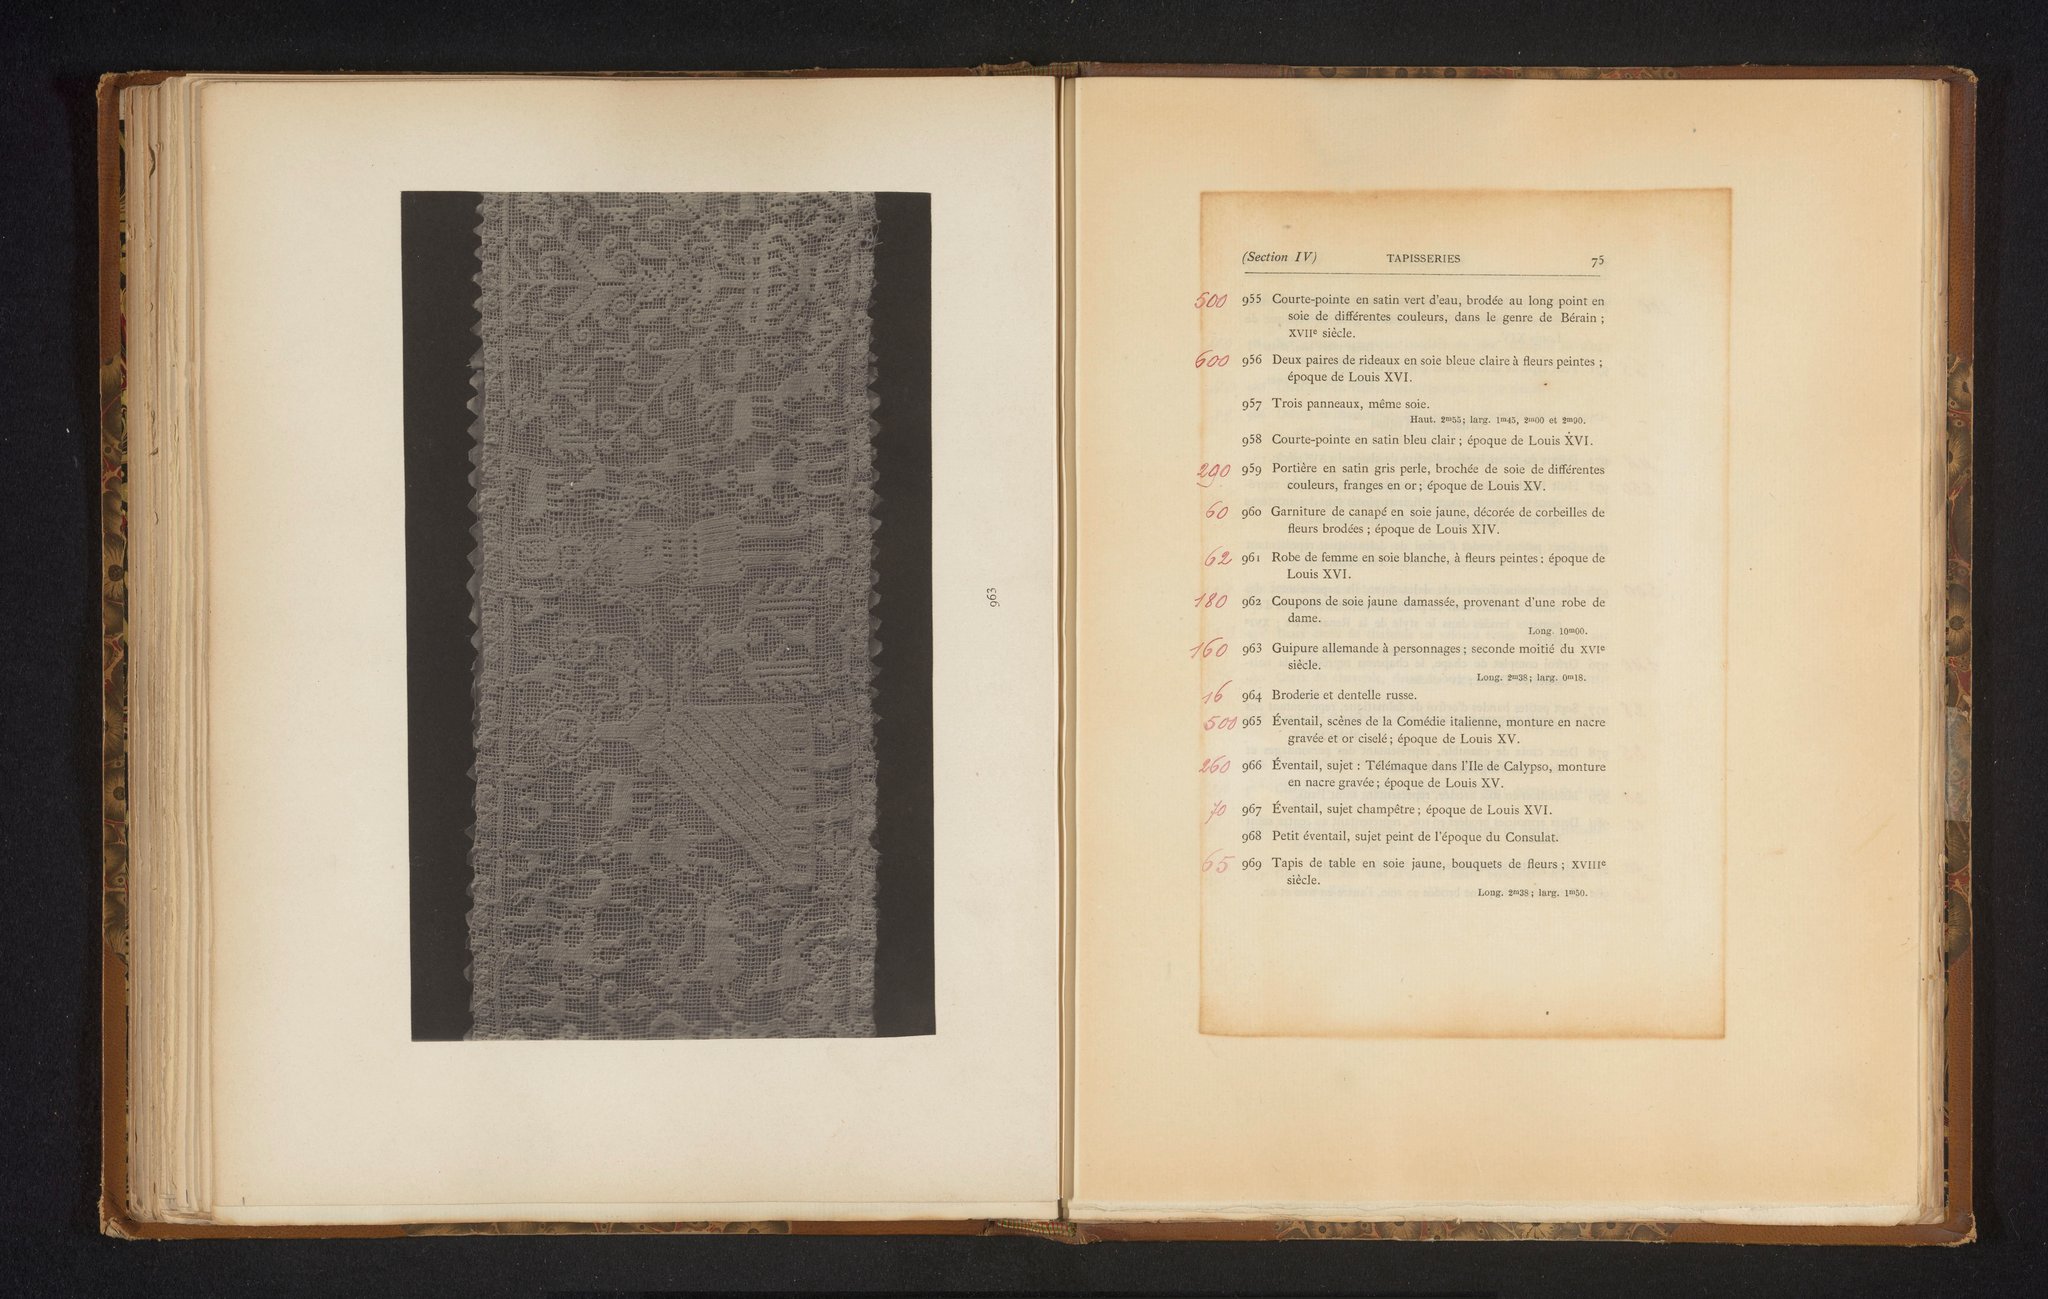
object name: photograph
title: Duitse voorstelling in kant uit de collectie van Antonin Terme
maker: Anonymous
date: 1880-1885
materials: photographic support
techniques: platinum process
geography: liège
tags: art collection, art gallery, lace